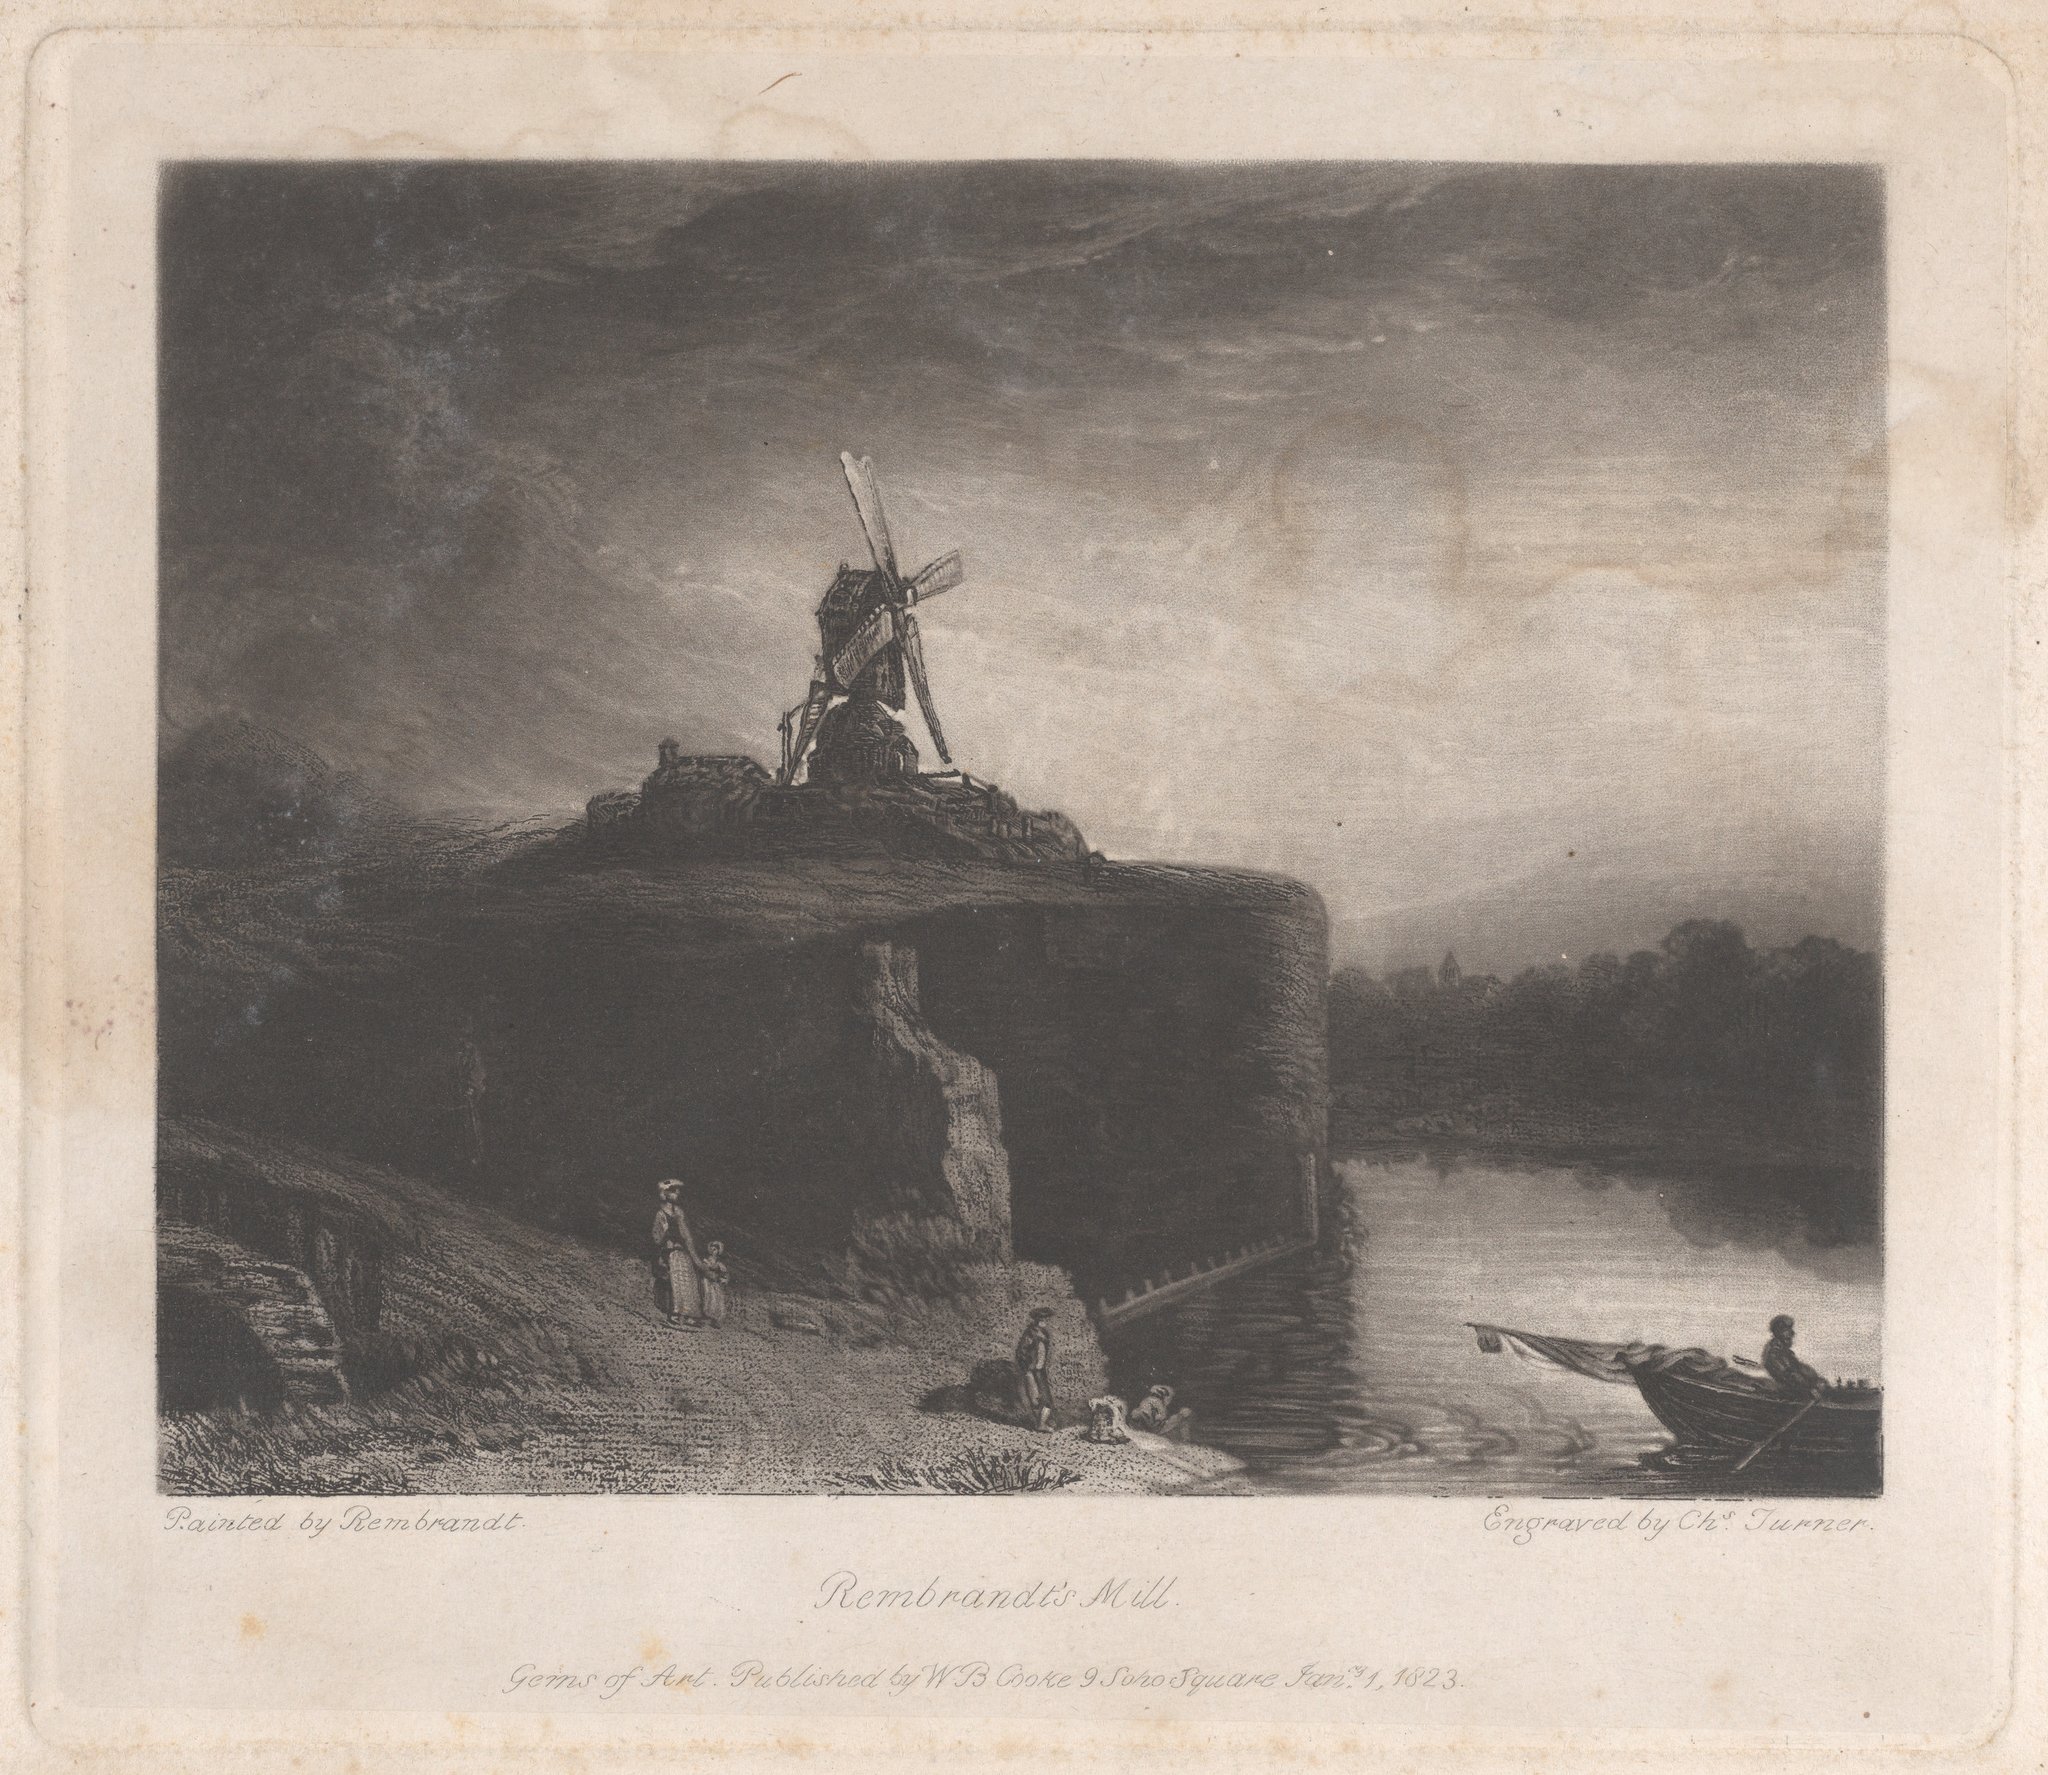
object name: print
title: Rembrandt's Mill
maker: charles turner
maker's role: artist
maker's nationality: british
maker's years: 1774-1857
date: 1823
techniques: printmaking, mezzotint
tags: windmills,landscapes,boats